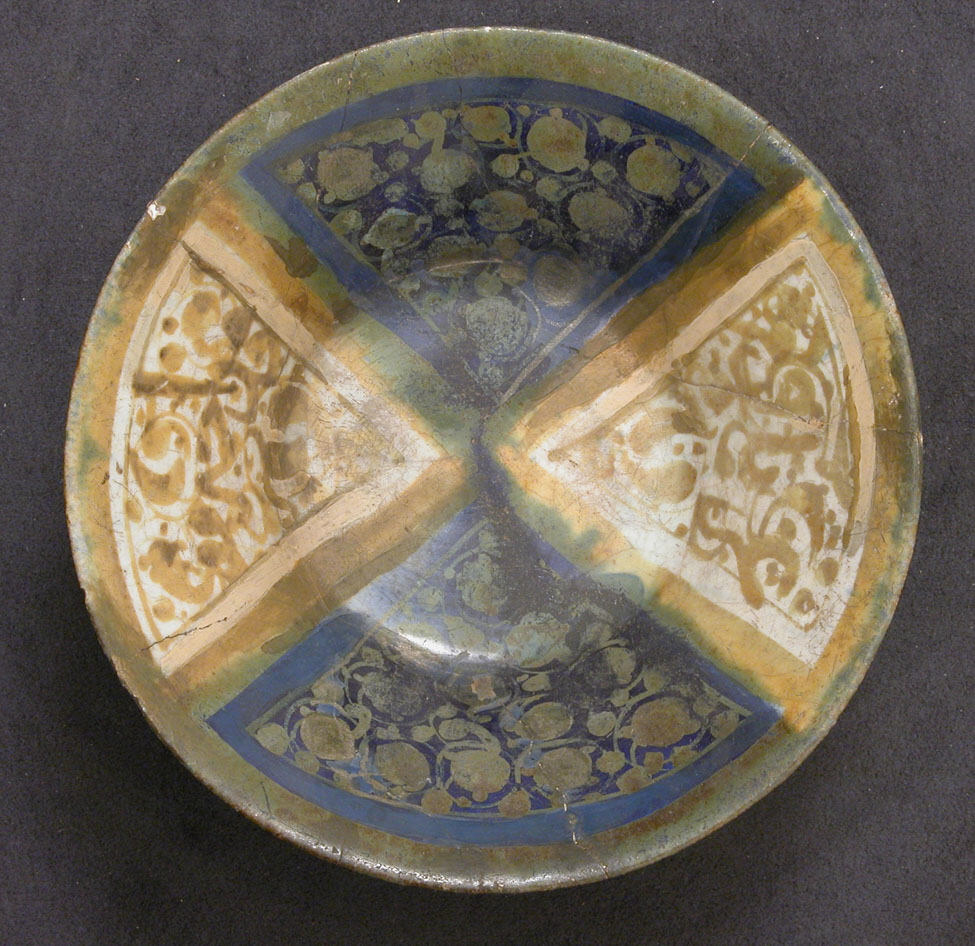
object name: bowl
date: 1101-1300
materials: stonepaste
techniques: luster painting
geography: iran